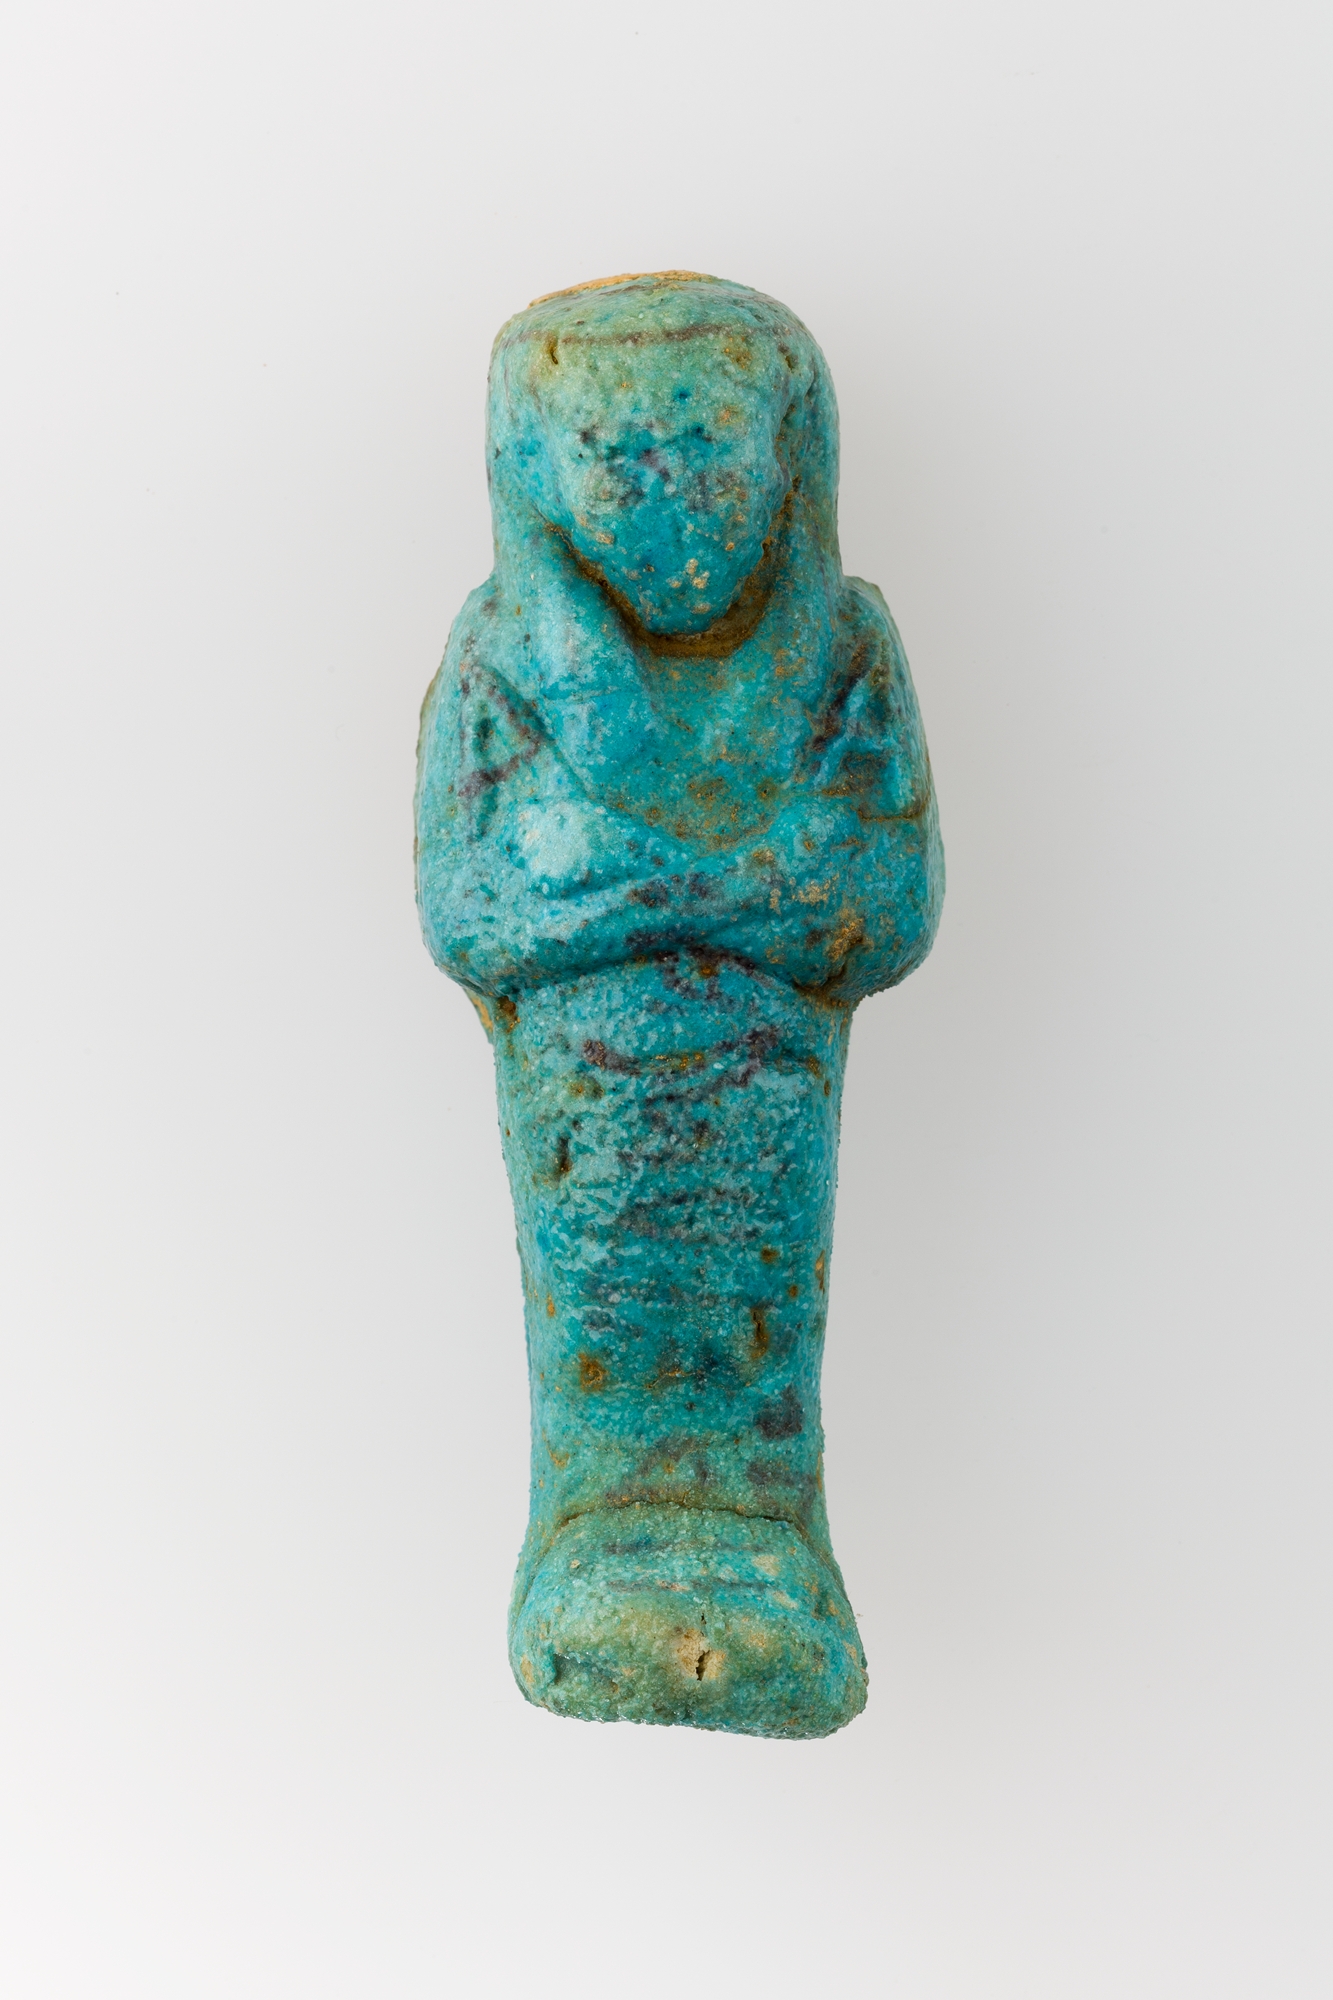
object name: shabti, henettawy c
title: Worker Shabti of Henettawy (C), Daughter of Isetemkheb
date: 990-970 BCE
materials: faience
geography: egypt